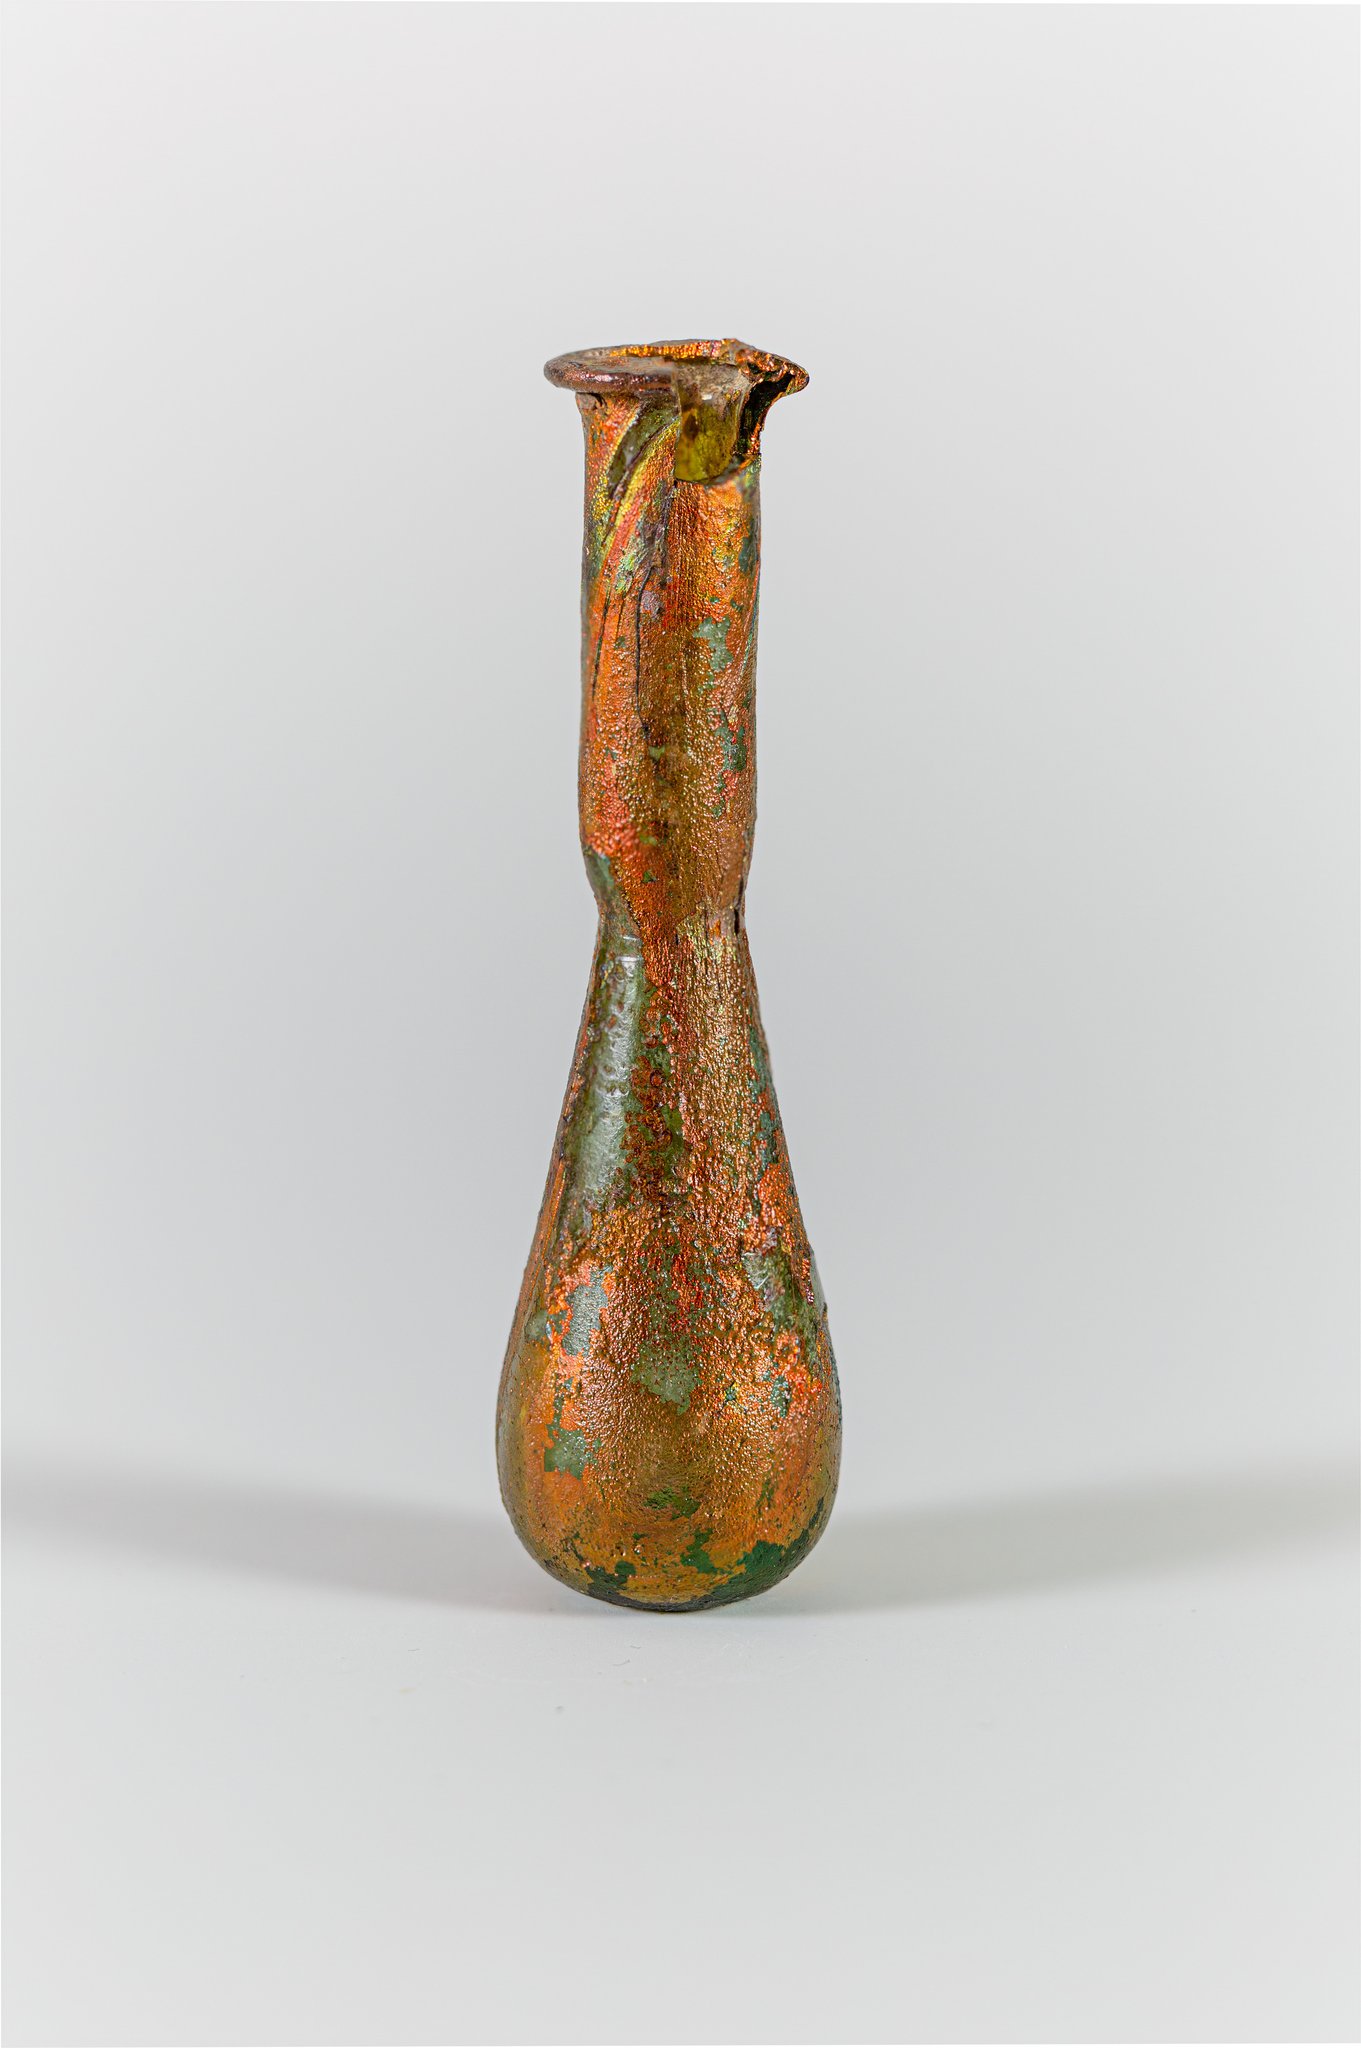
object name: perfume bottle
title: Glass perfume bottle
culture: roman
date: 67-300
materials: glass